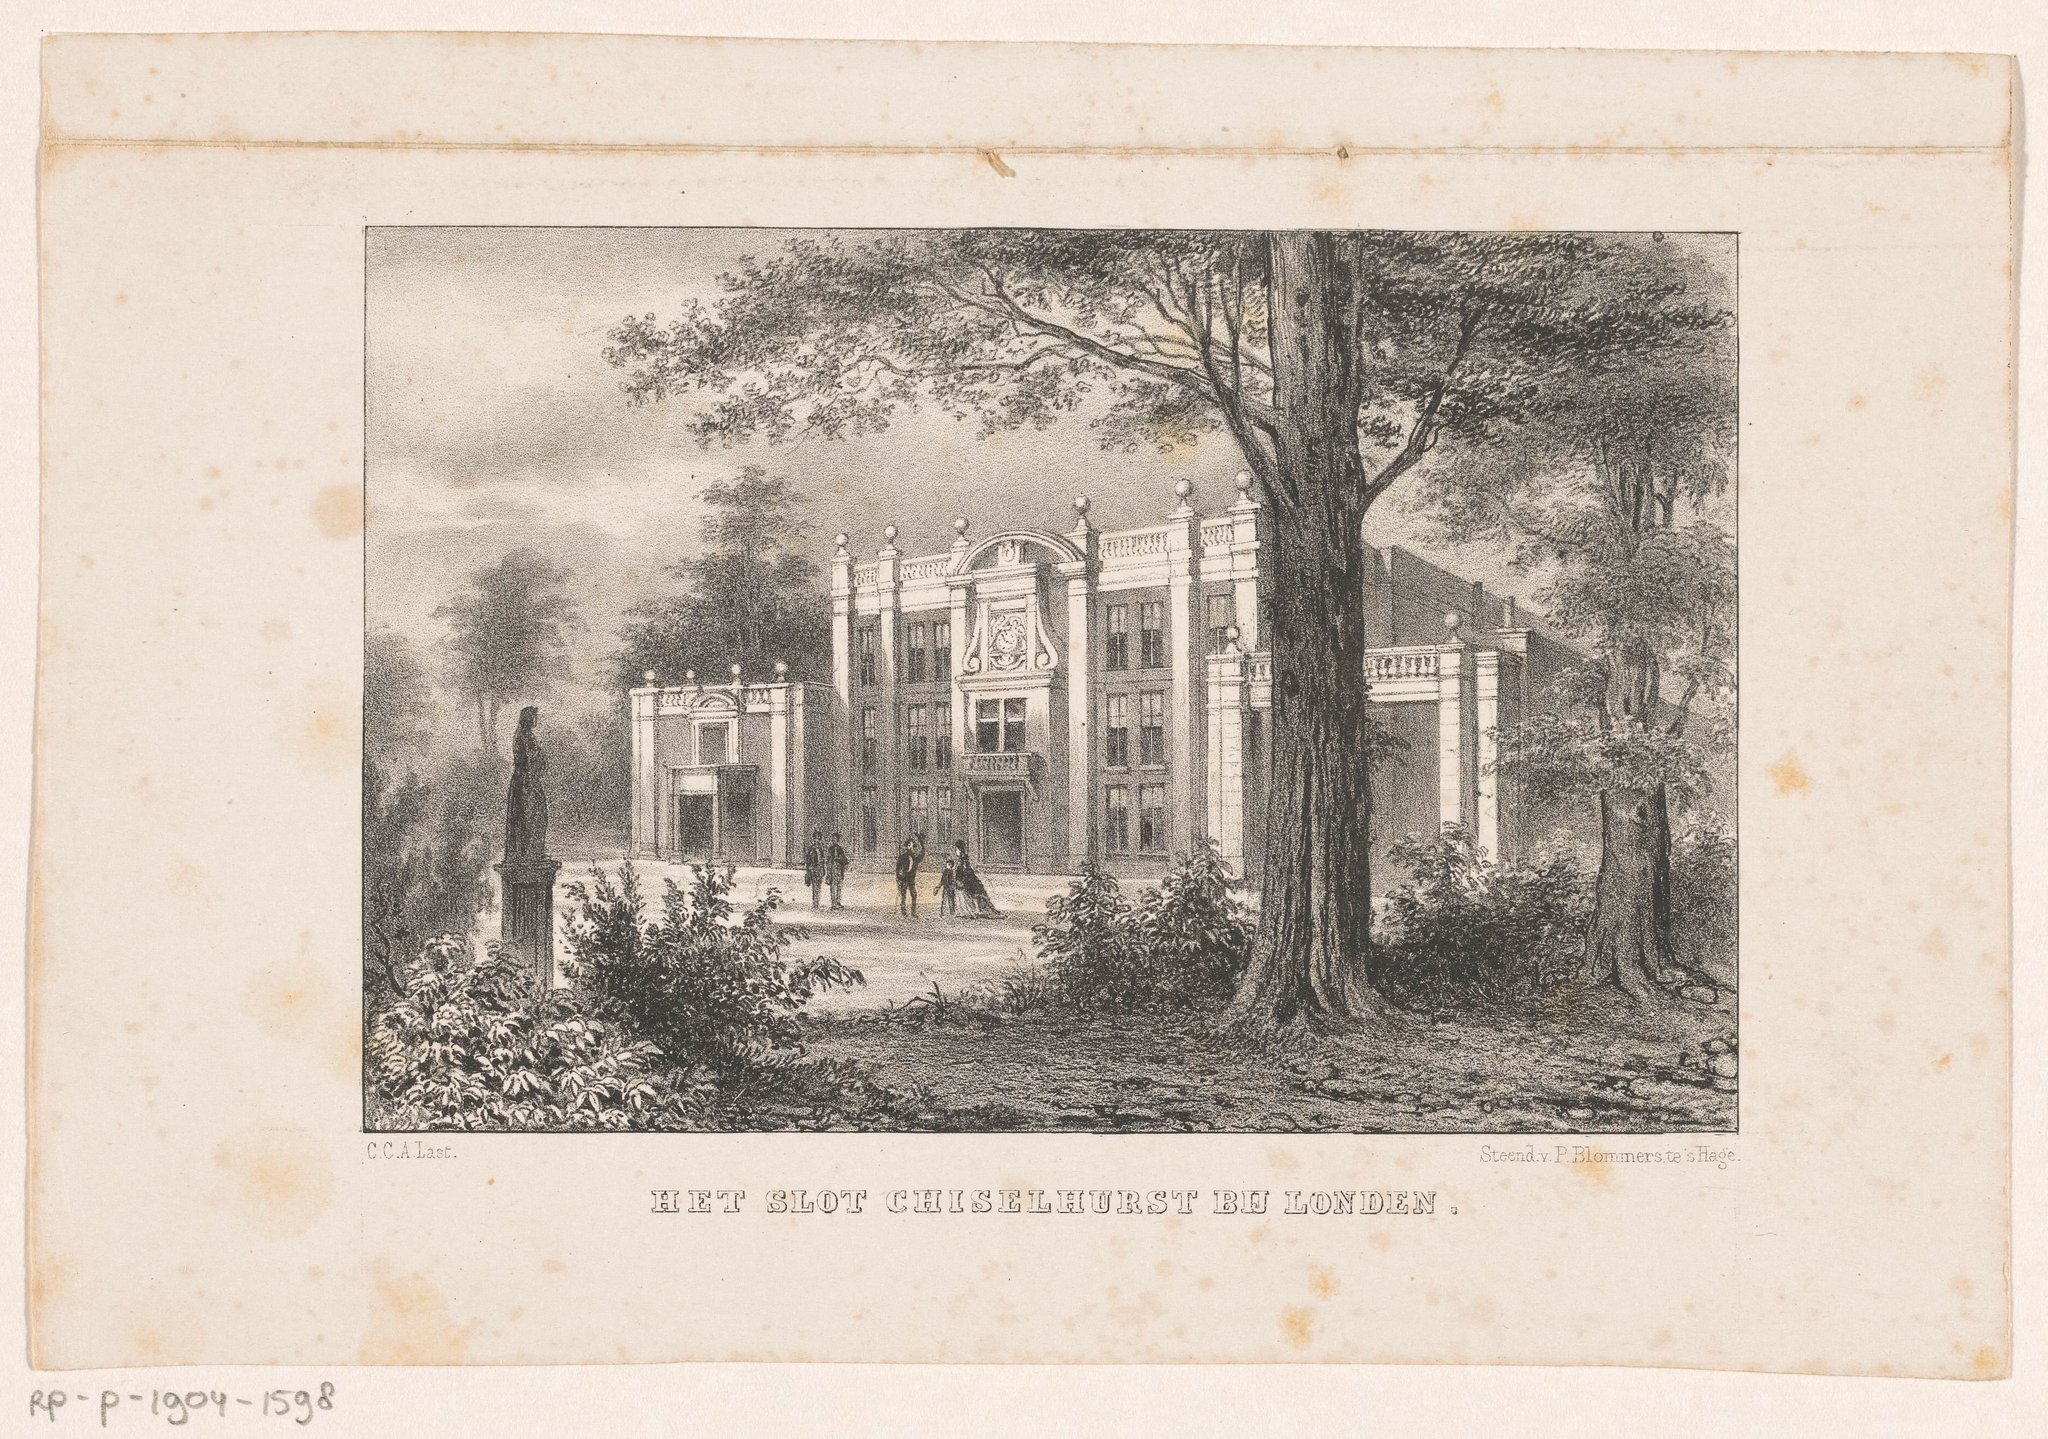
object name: print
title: Camden Place in Chislehurst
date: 1842-1887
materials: paper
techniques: lithograph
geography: the hague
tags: summer, 'aestas'; 'estate' (ripa), baring the head, lifting one's hat, farm or solitary house in landscape, statues, sculptures in garden, london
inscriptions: collector's mark: Lugt 2228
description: Voor het gebouw staan enkele figuren, een man begroet een vrouw en kind. In de tuin een sculptuur op een sokkel.